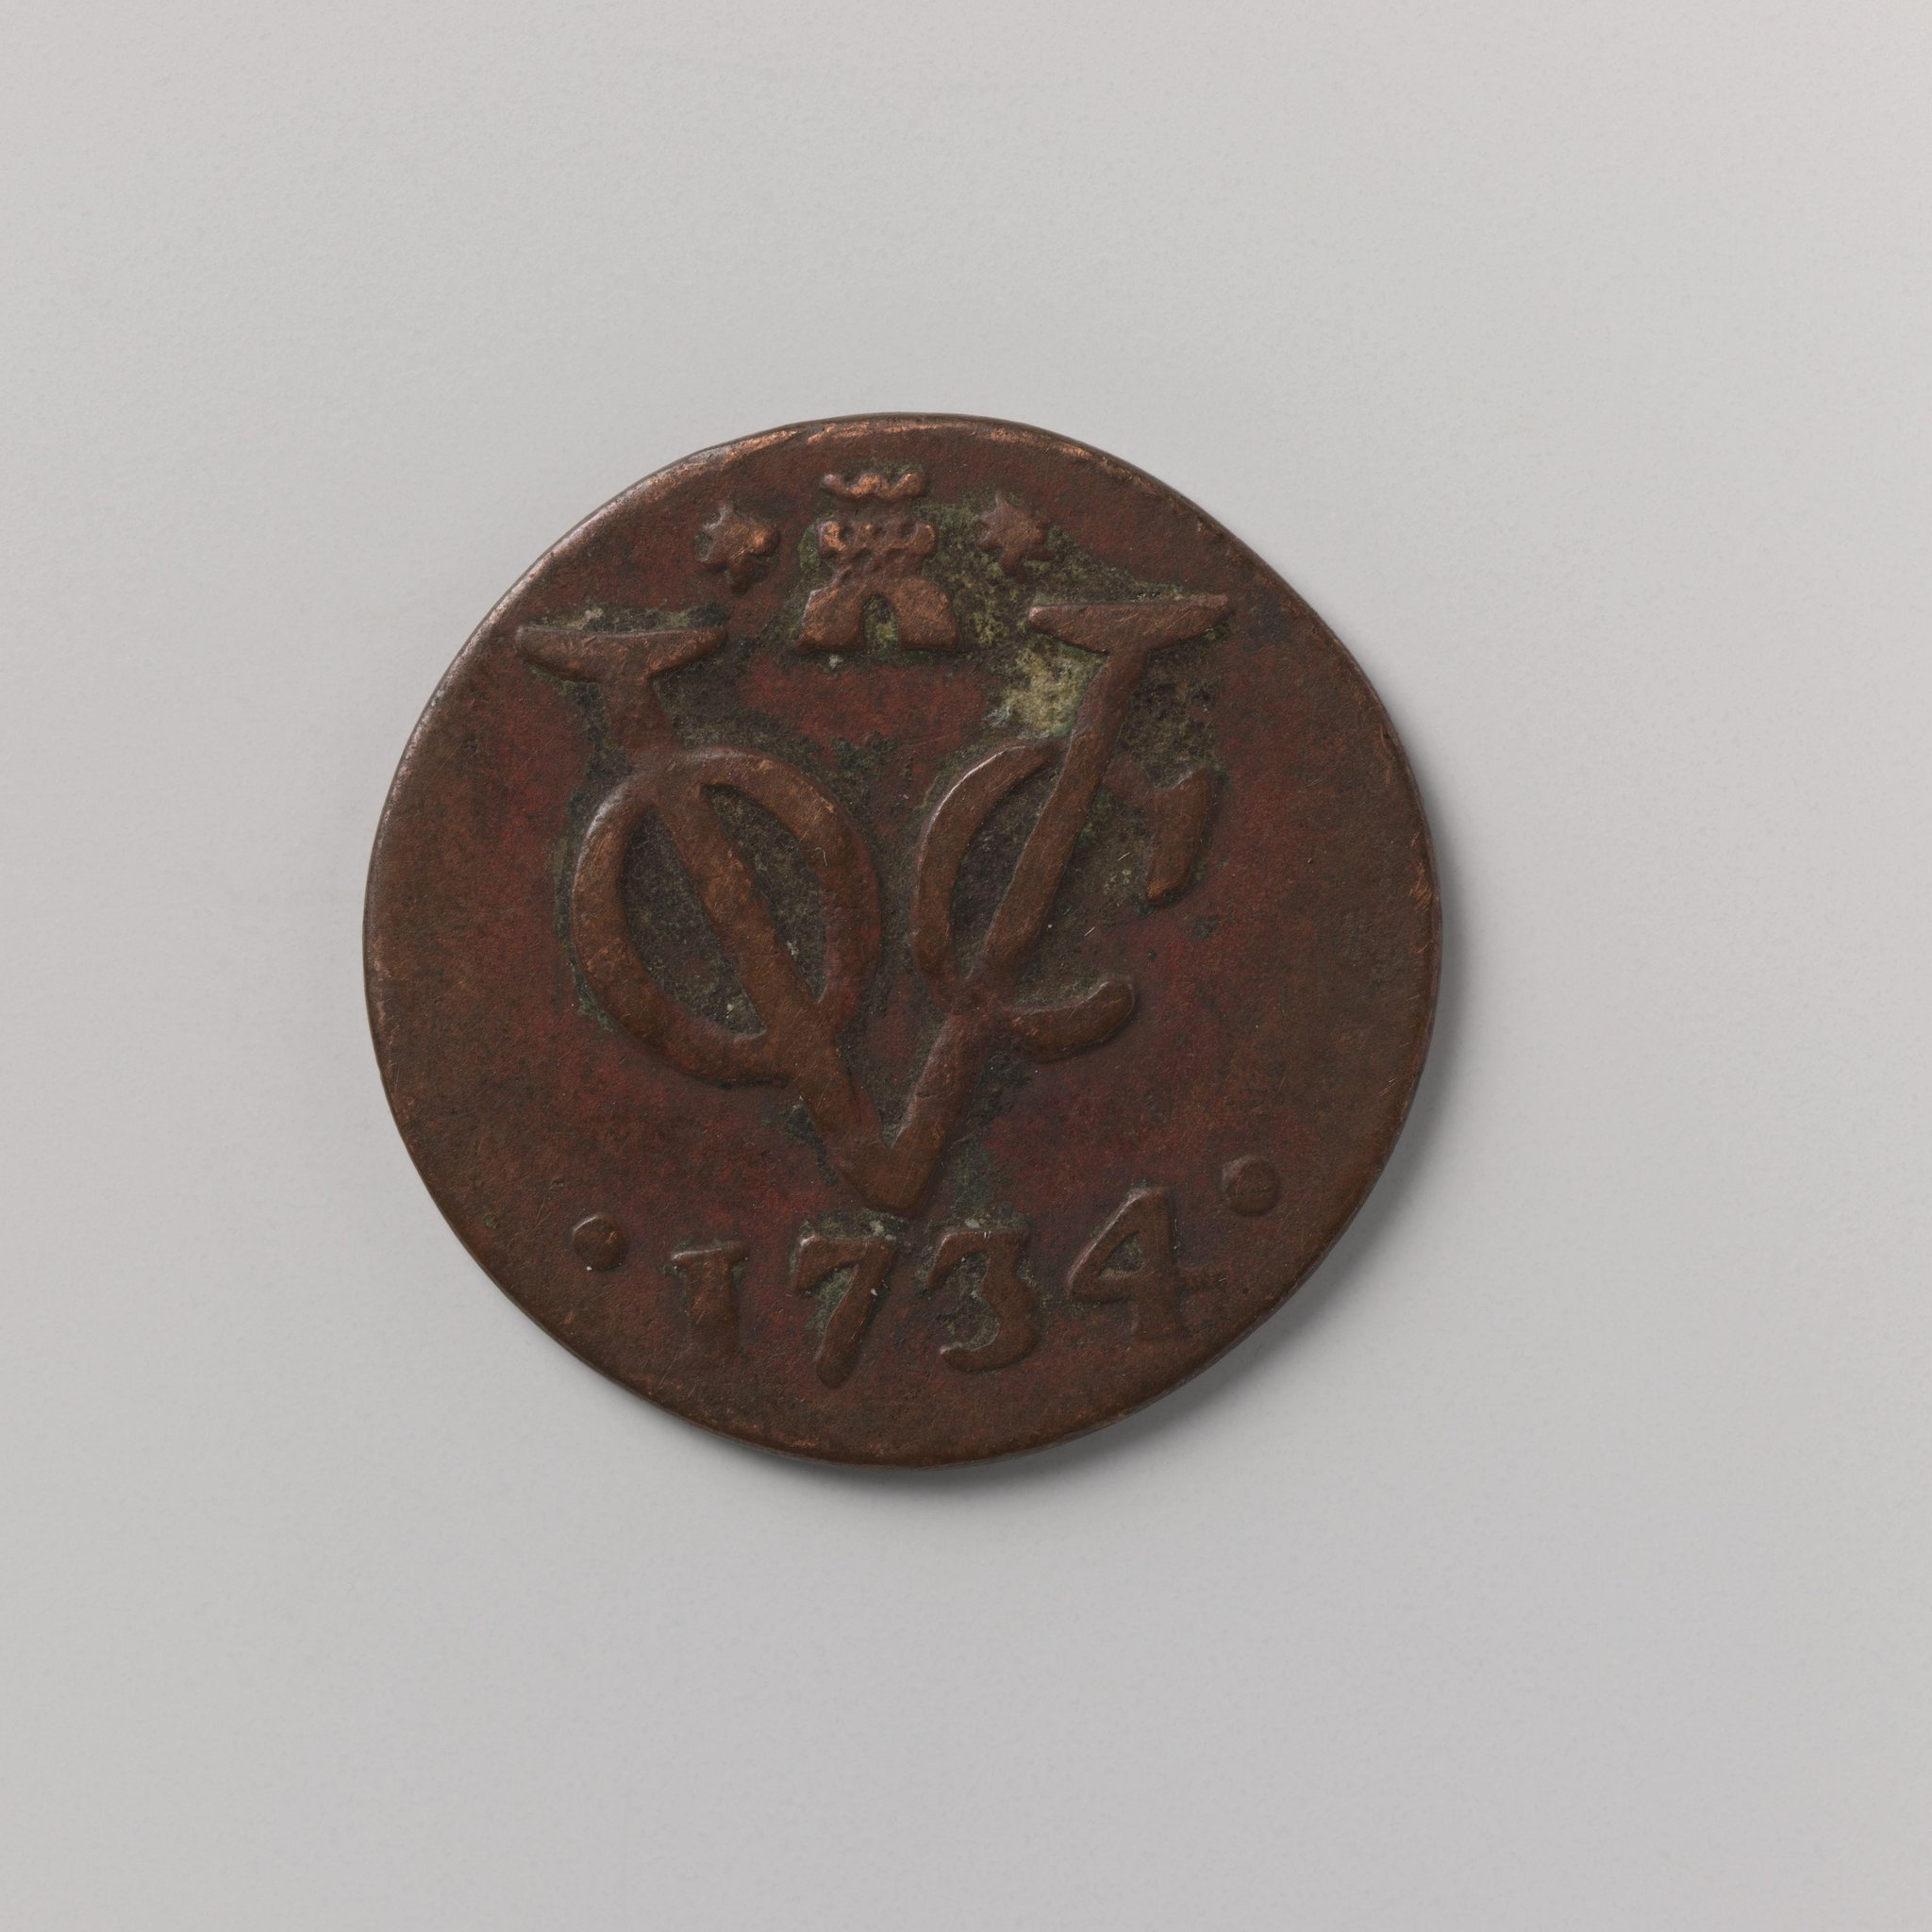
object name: coin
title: Duit van de VOC uit Zeeland, 1734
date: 1734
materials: copper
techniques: striking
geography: middelburg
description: Koperen munt. Voorzijde: gekroond wapenschild van Zeeland. Keerzijde: monogram van de VOC, waarboven muntteken en waaronder jaartal. Gladde rand.